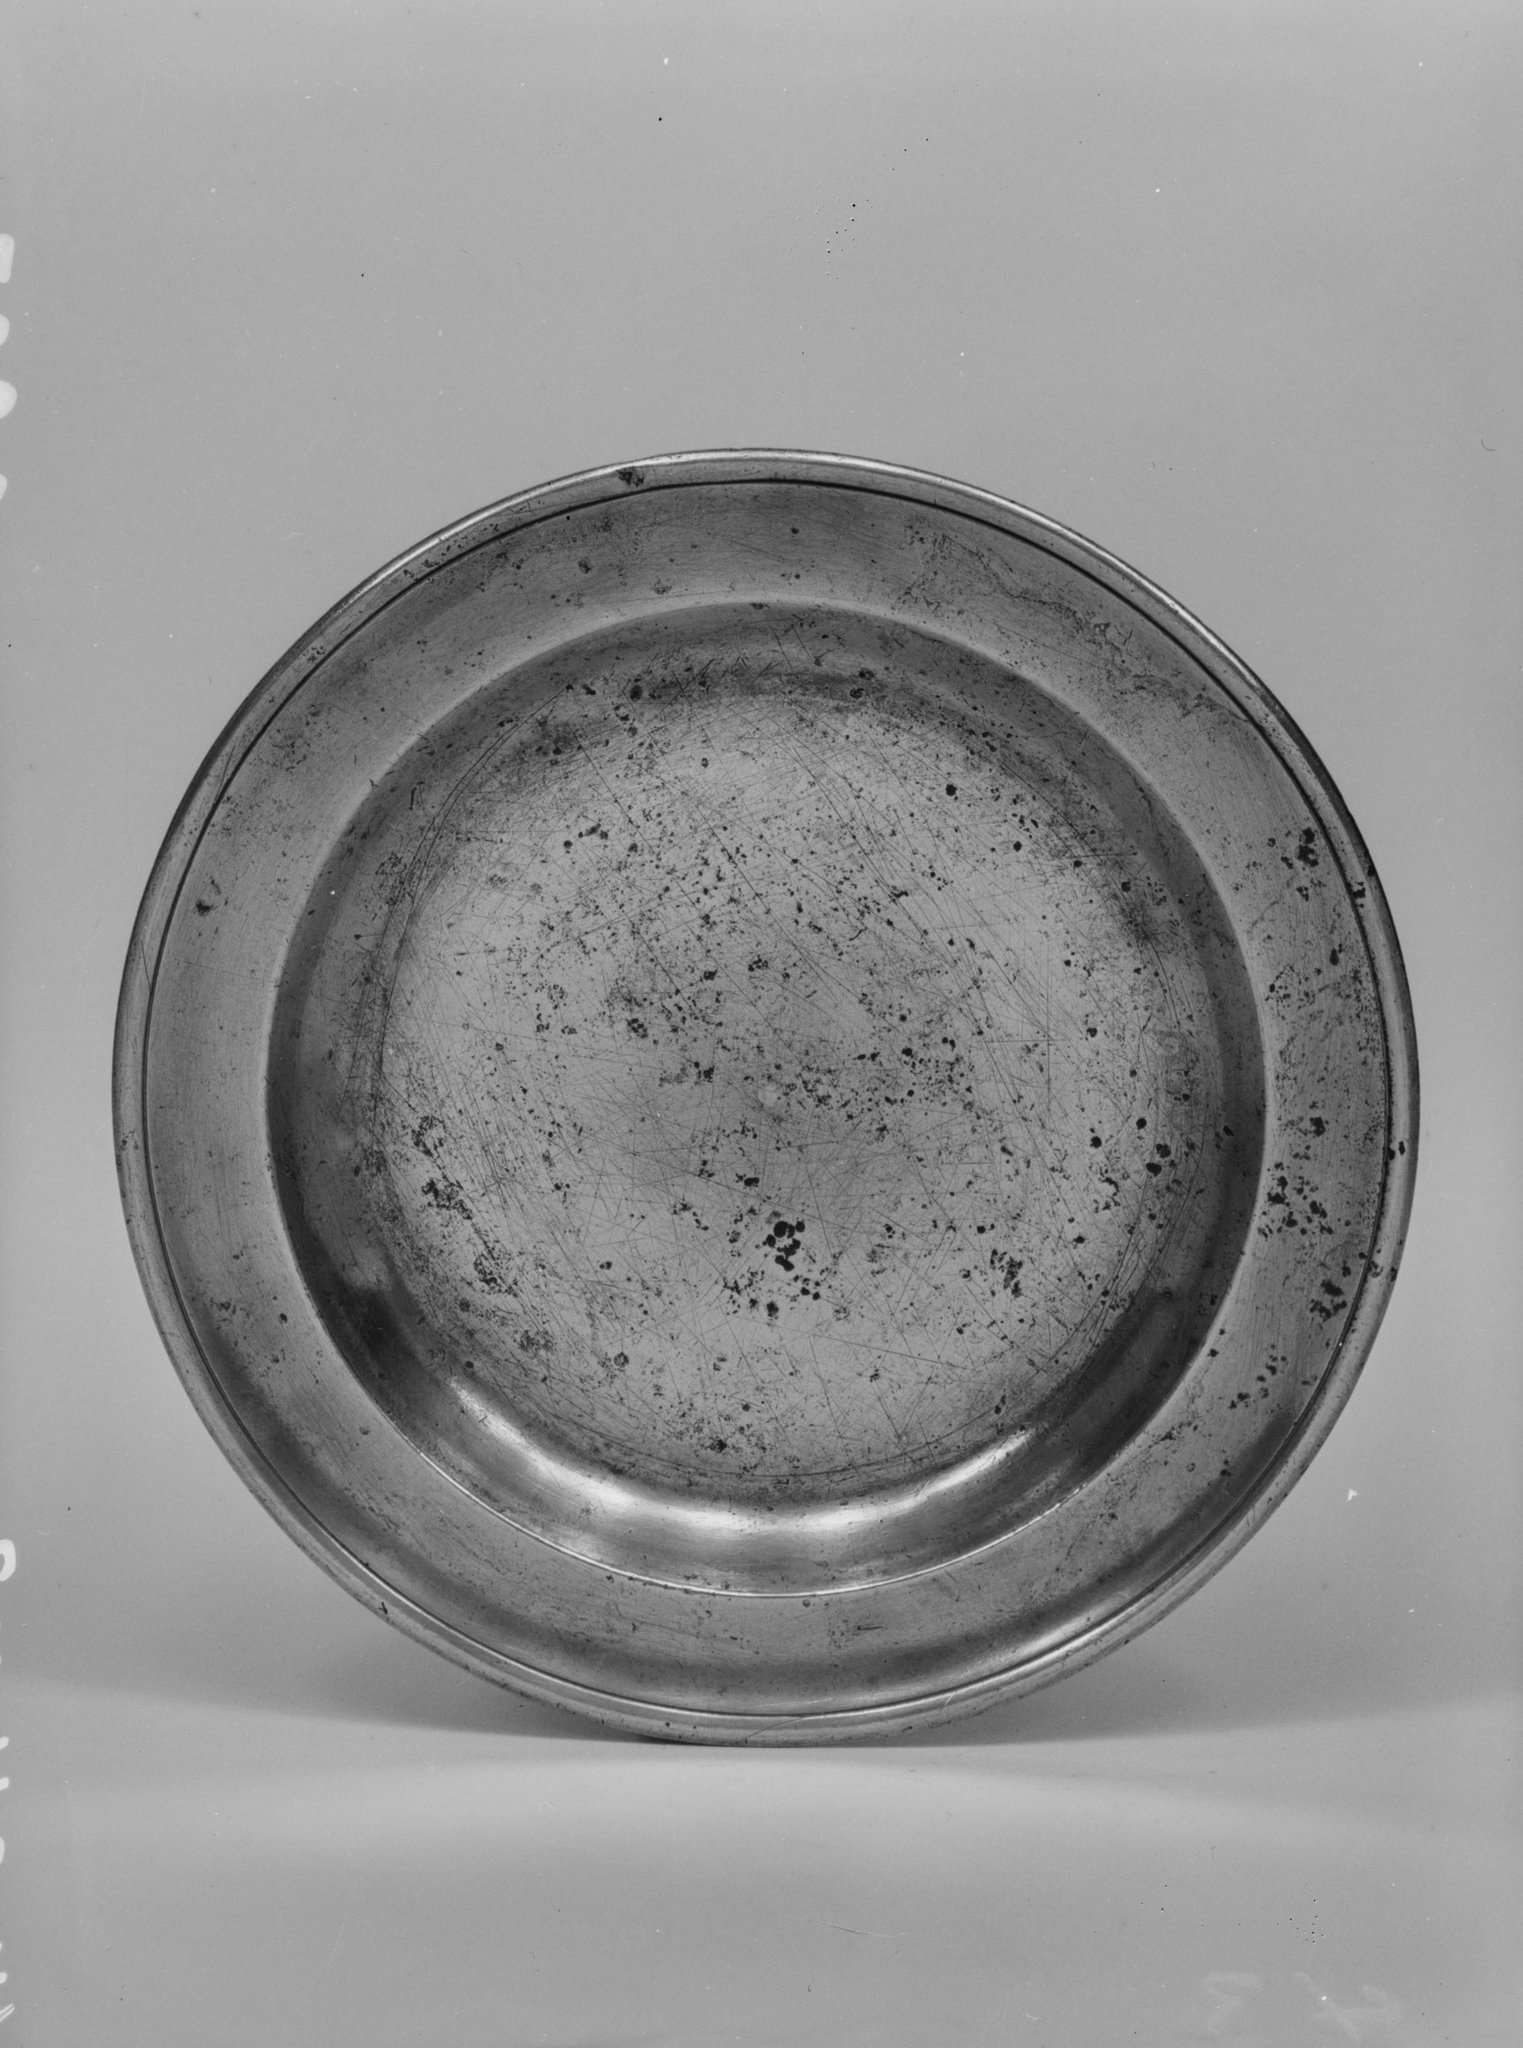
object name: plate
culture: american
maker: hiram yale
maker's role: maker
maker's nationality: american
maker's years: 1799-1831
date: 1822-1831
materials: pewter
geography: united states